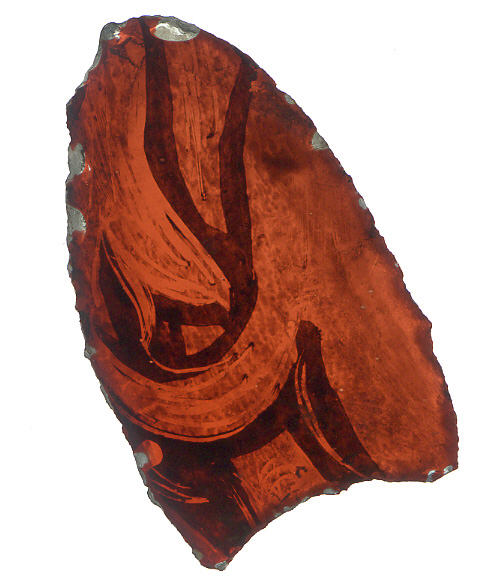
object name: fragment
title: Glass Fragment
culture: european, western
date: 1401-1500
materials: glass, metal